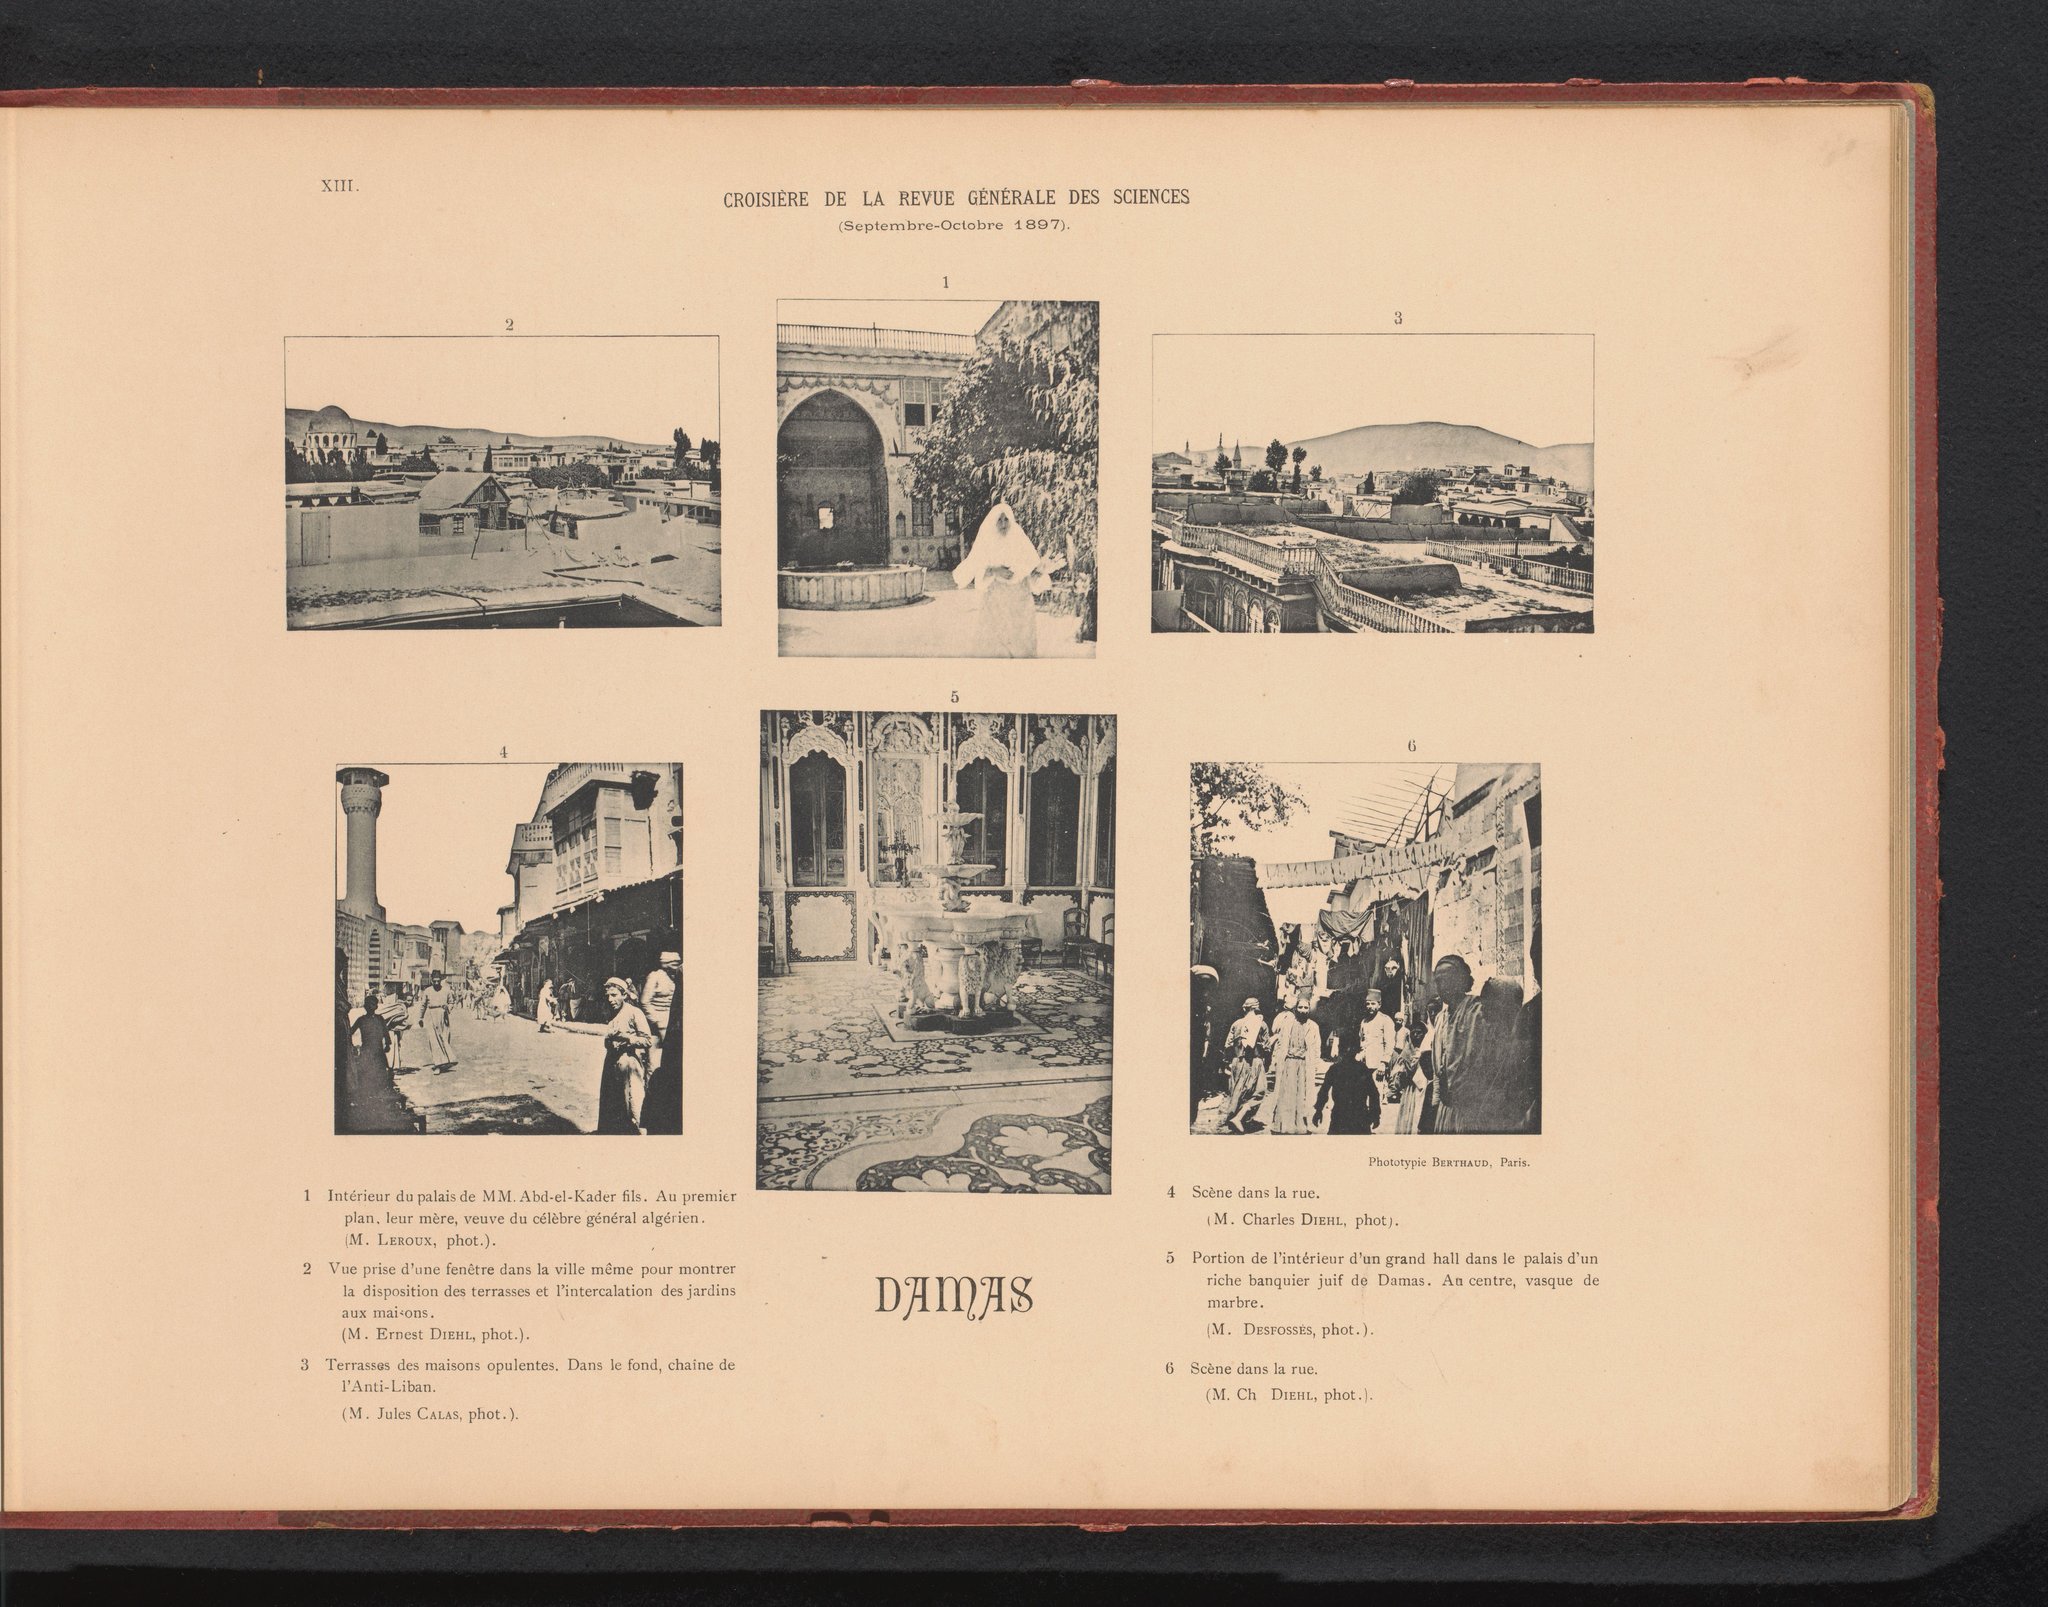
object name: photomechanical print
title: Zes gezichten op Damascus, Syrië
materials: paper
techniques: photograph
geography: damascus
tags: palace - aa - civic architecture: inside, street, prospect of city, town panorama, silhouette of city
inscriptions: number: ‘XIII.’, inscription: ‘1 Intérieur du palais de MM. Abd-el-Kader fils. Au premier/ plan, leur mère, veuve du célèbre général algérien./ (M. Leroux, phot.)./ 2 Vue prise d'une fenêtre dans la ville même pour montrer/ la disposition des terrasses et l'intercalation des jardins/ aux mai[so]ns./ (M. Ernest Diehl, phot.)./ 3 Terrasses des maisons opulentes. Dans le fond, chaîne de/ l'Anti-Liban./ (M. Jules Calas, phot.)./ 4 Scène dans la rue./ (M. Charles Diehl, phot )./ 5 Portion de l'intérieur d'un grand hall dans le palais d'un riche banquier juif de Damas. Au centre, vasque de marbe./ (M. Desfosses, phot.)./ 6 Scène dans la rue./ (M. Ch Diehl, phot.).’